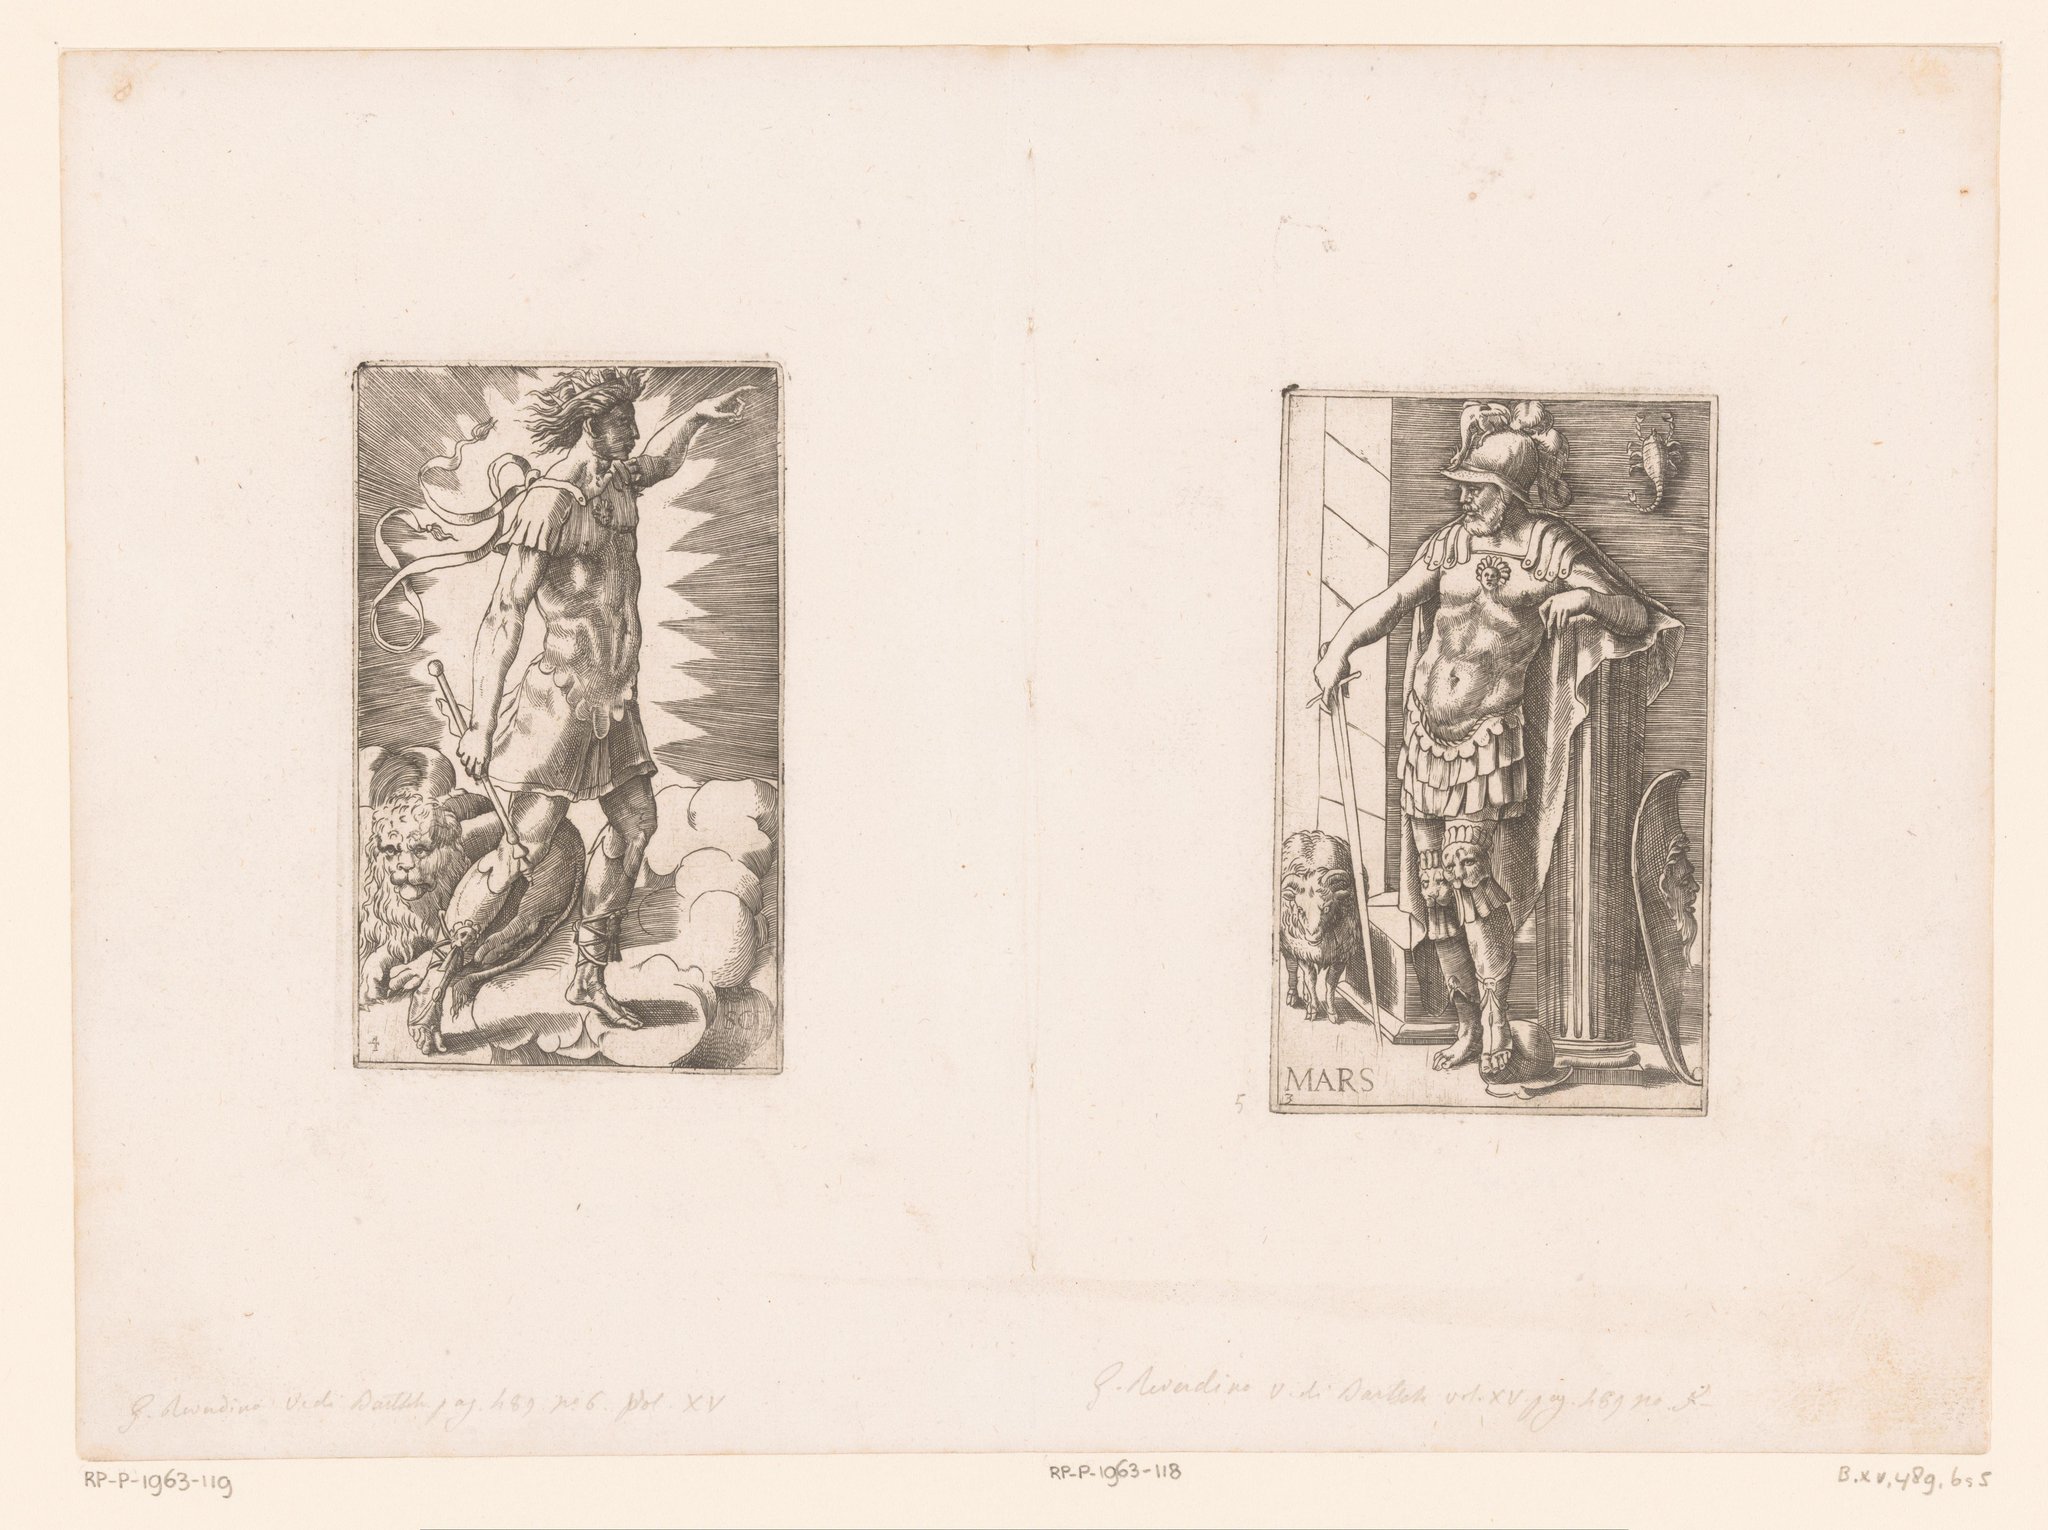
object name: print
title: Mars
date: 1536-1569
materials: paper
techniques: engraving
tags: (story of) mars (ares), mars and his children ('planetenkinder')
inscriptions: collector's mark: Lugt 2228, collector's mark: Lugt 2760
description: Prent staat samen met RP-P-1963-119 op een onversneden blad.